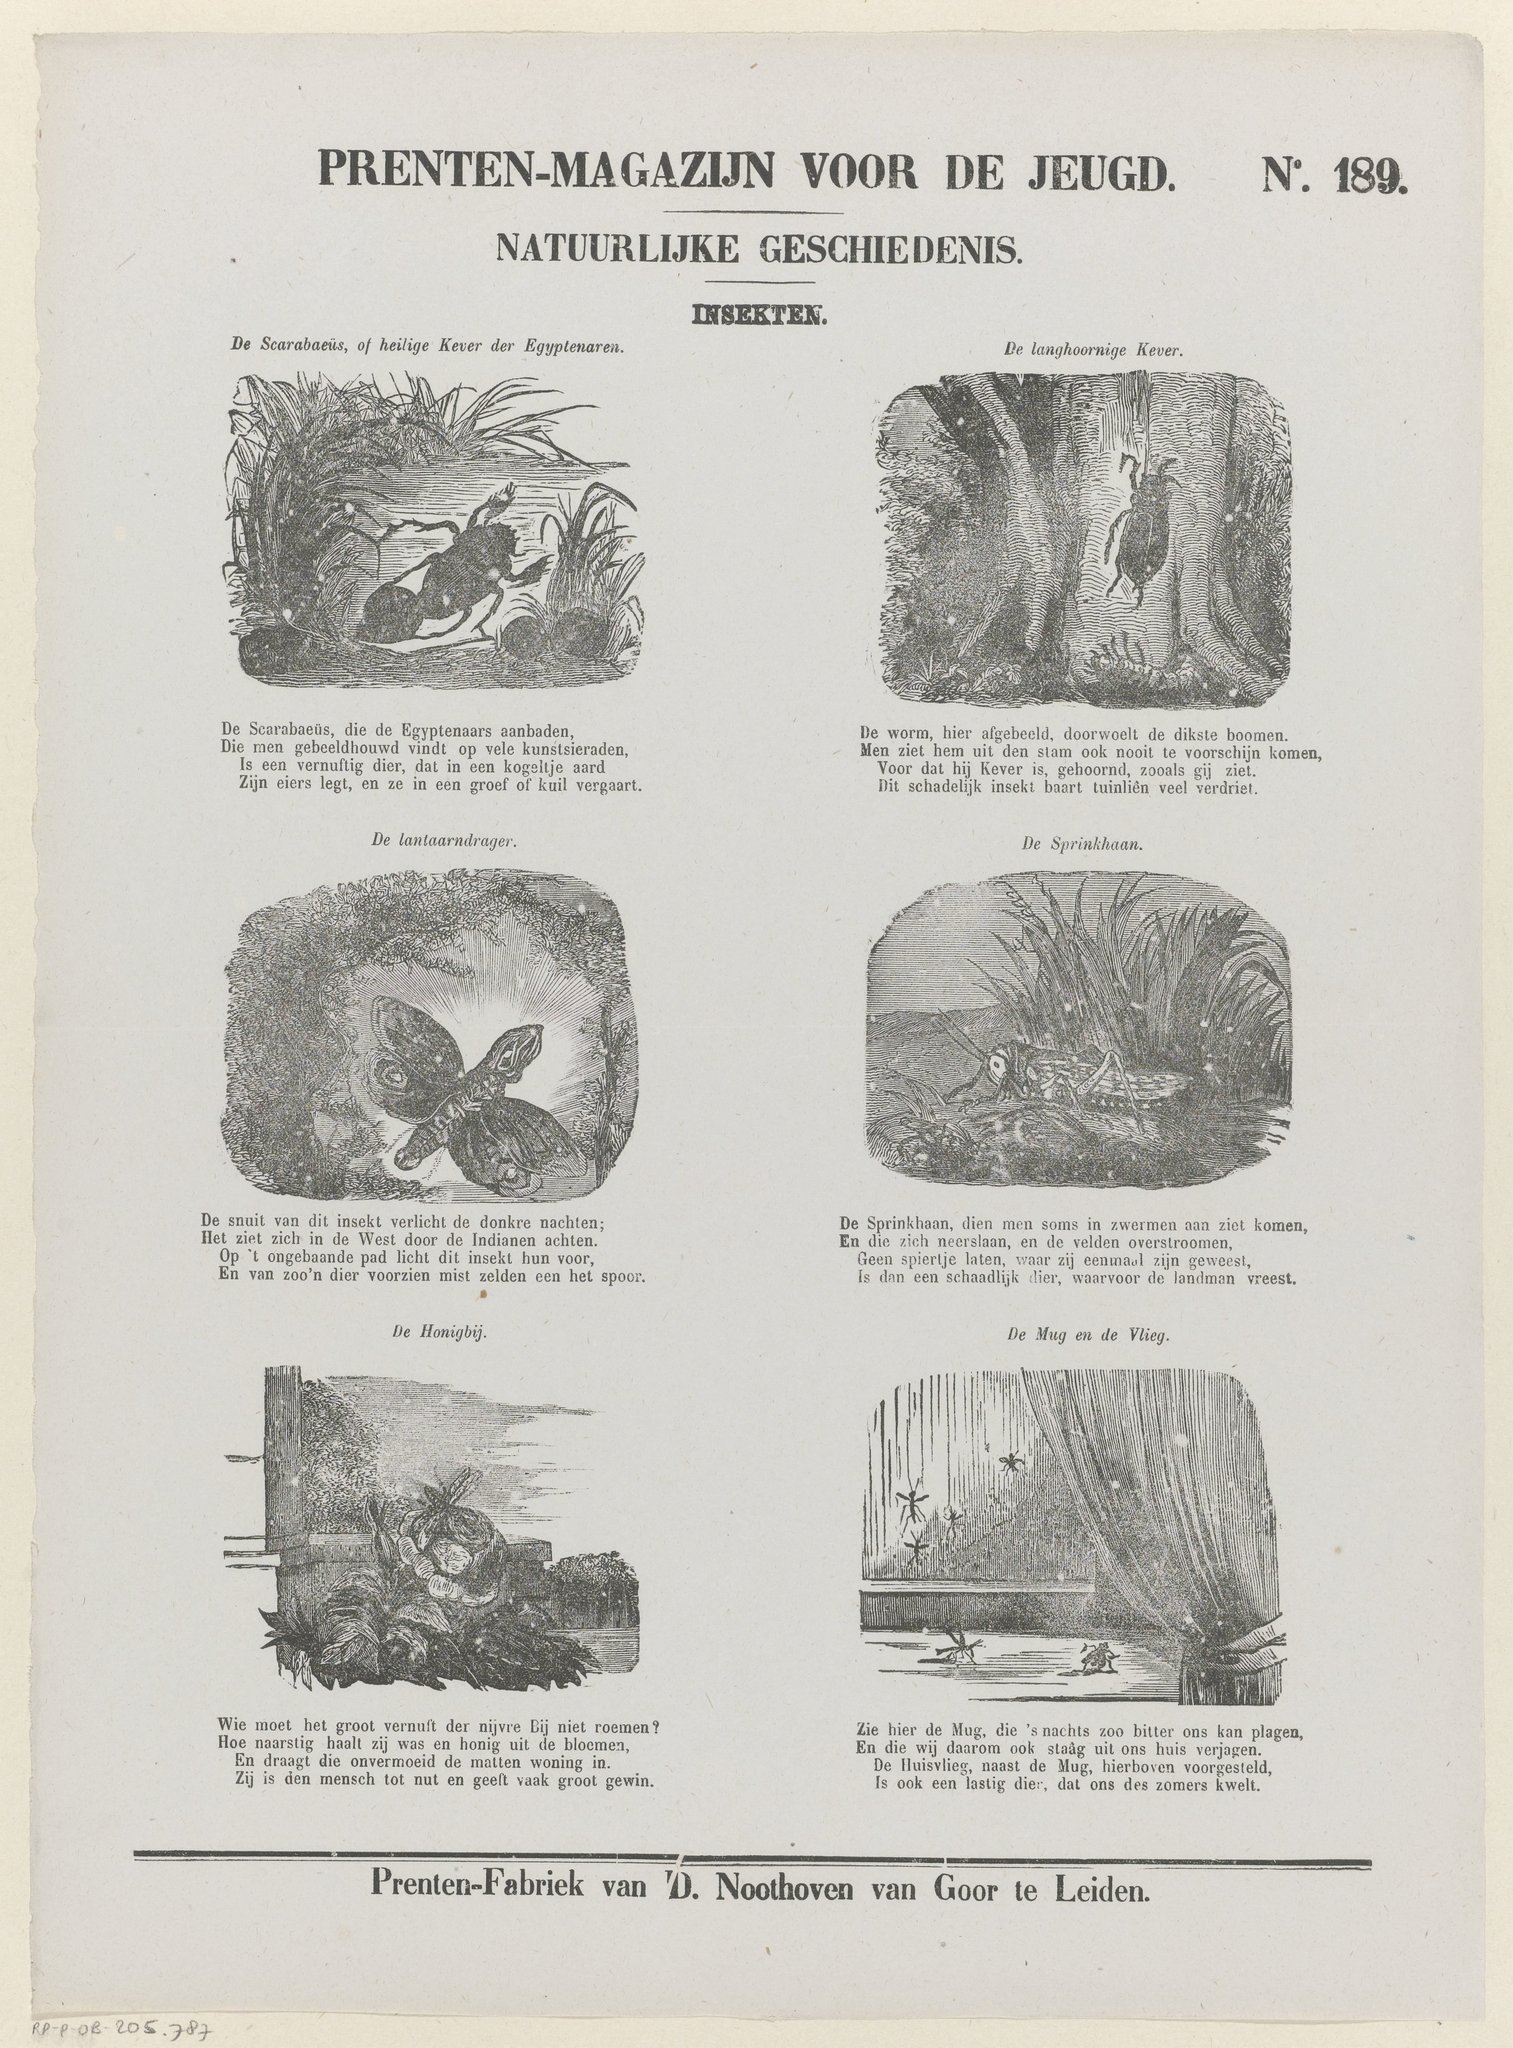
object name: popular print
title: Insekten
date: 1850-1881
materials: paper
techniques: letterpress printing, engraving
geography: netherlands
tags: insects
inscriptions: collector's mark: Lugt 2760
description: Blad met 6 voorstellingen van insekten. Boven elke afbeelding een titel, onder elke afbeelding een vierregelig vers. Genummerd rechtsboven: No. 189.